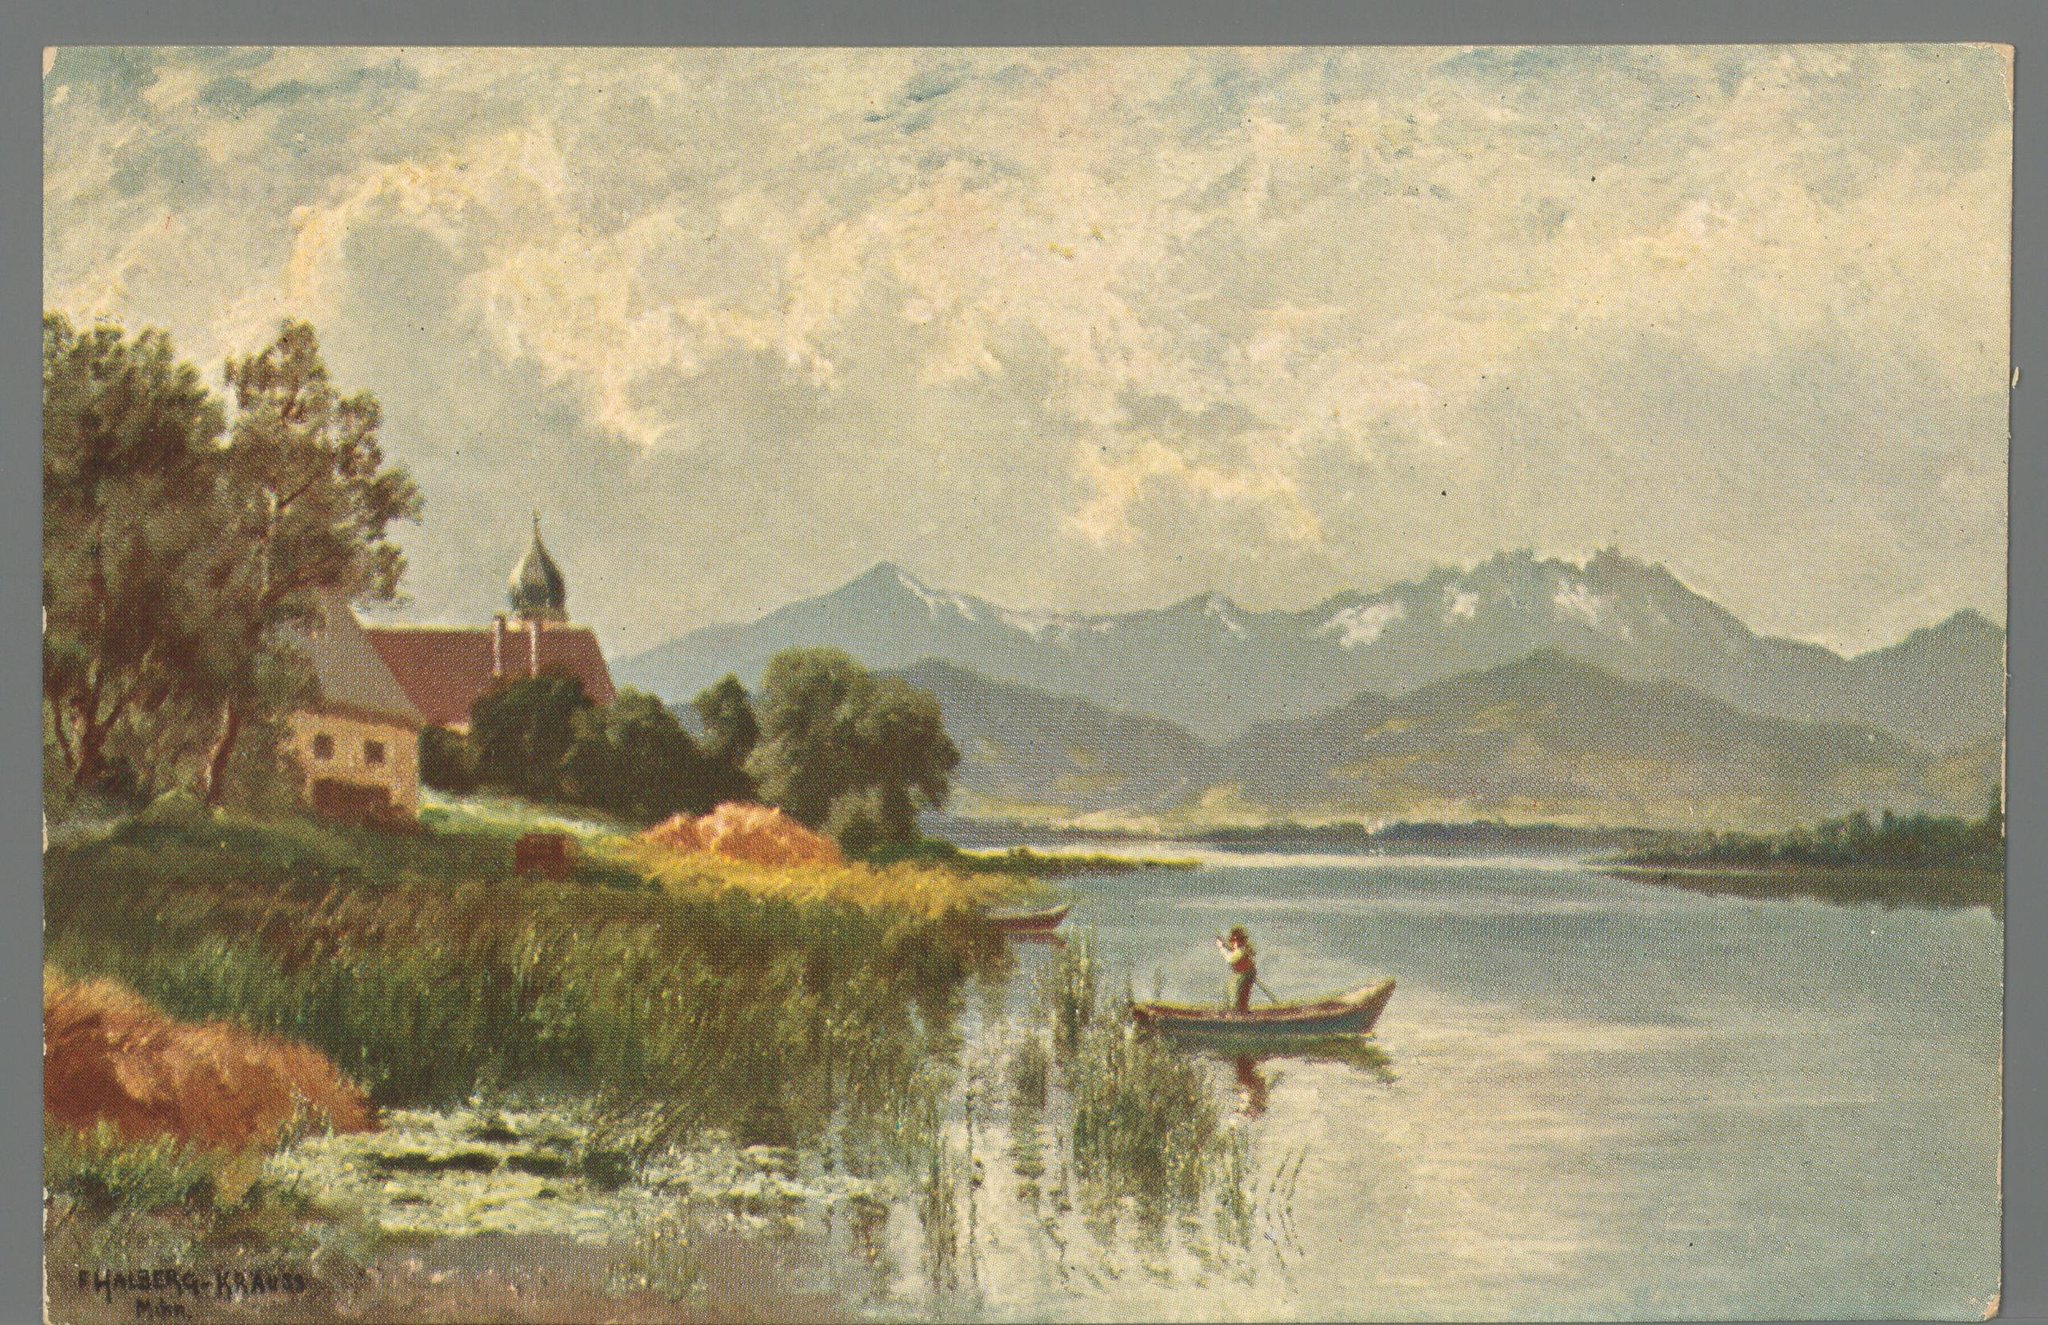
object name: reproduction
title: Langens Künstler-Karten Serie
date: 1905-1930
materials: cardboard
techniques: color autotype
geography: munich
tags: island, lake